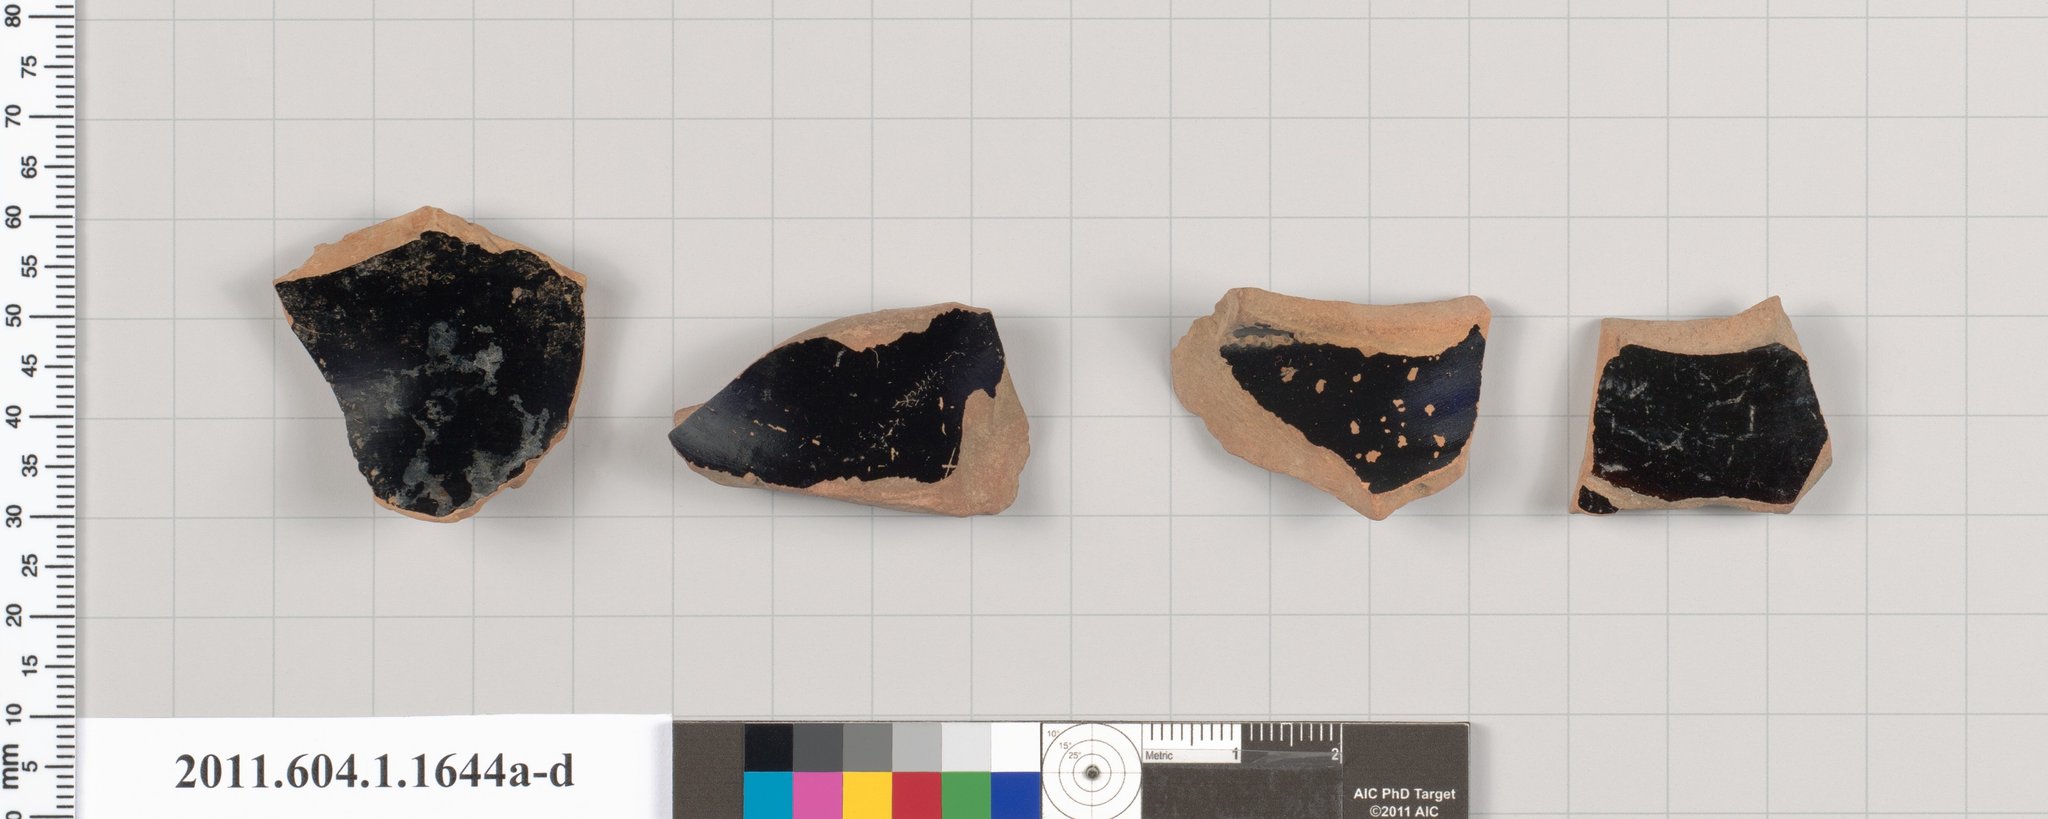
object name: kylix fragment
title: Terracotta fragments of kylikes (drinking cups)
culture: greek, attic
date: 500-401 BCE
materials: terracotta